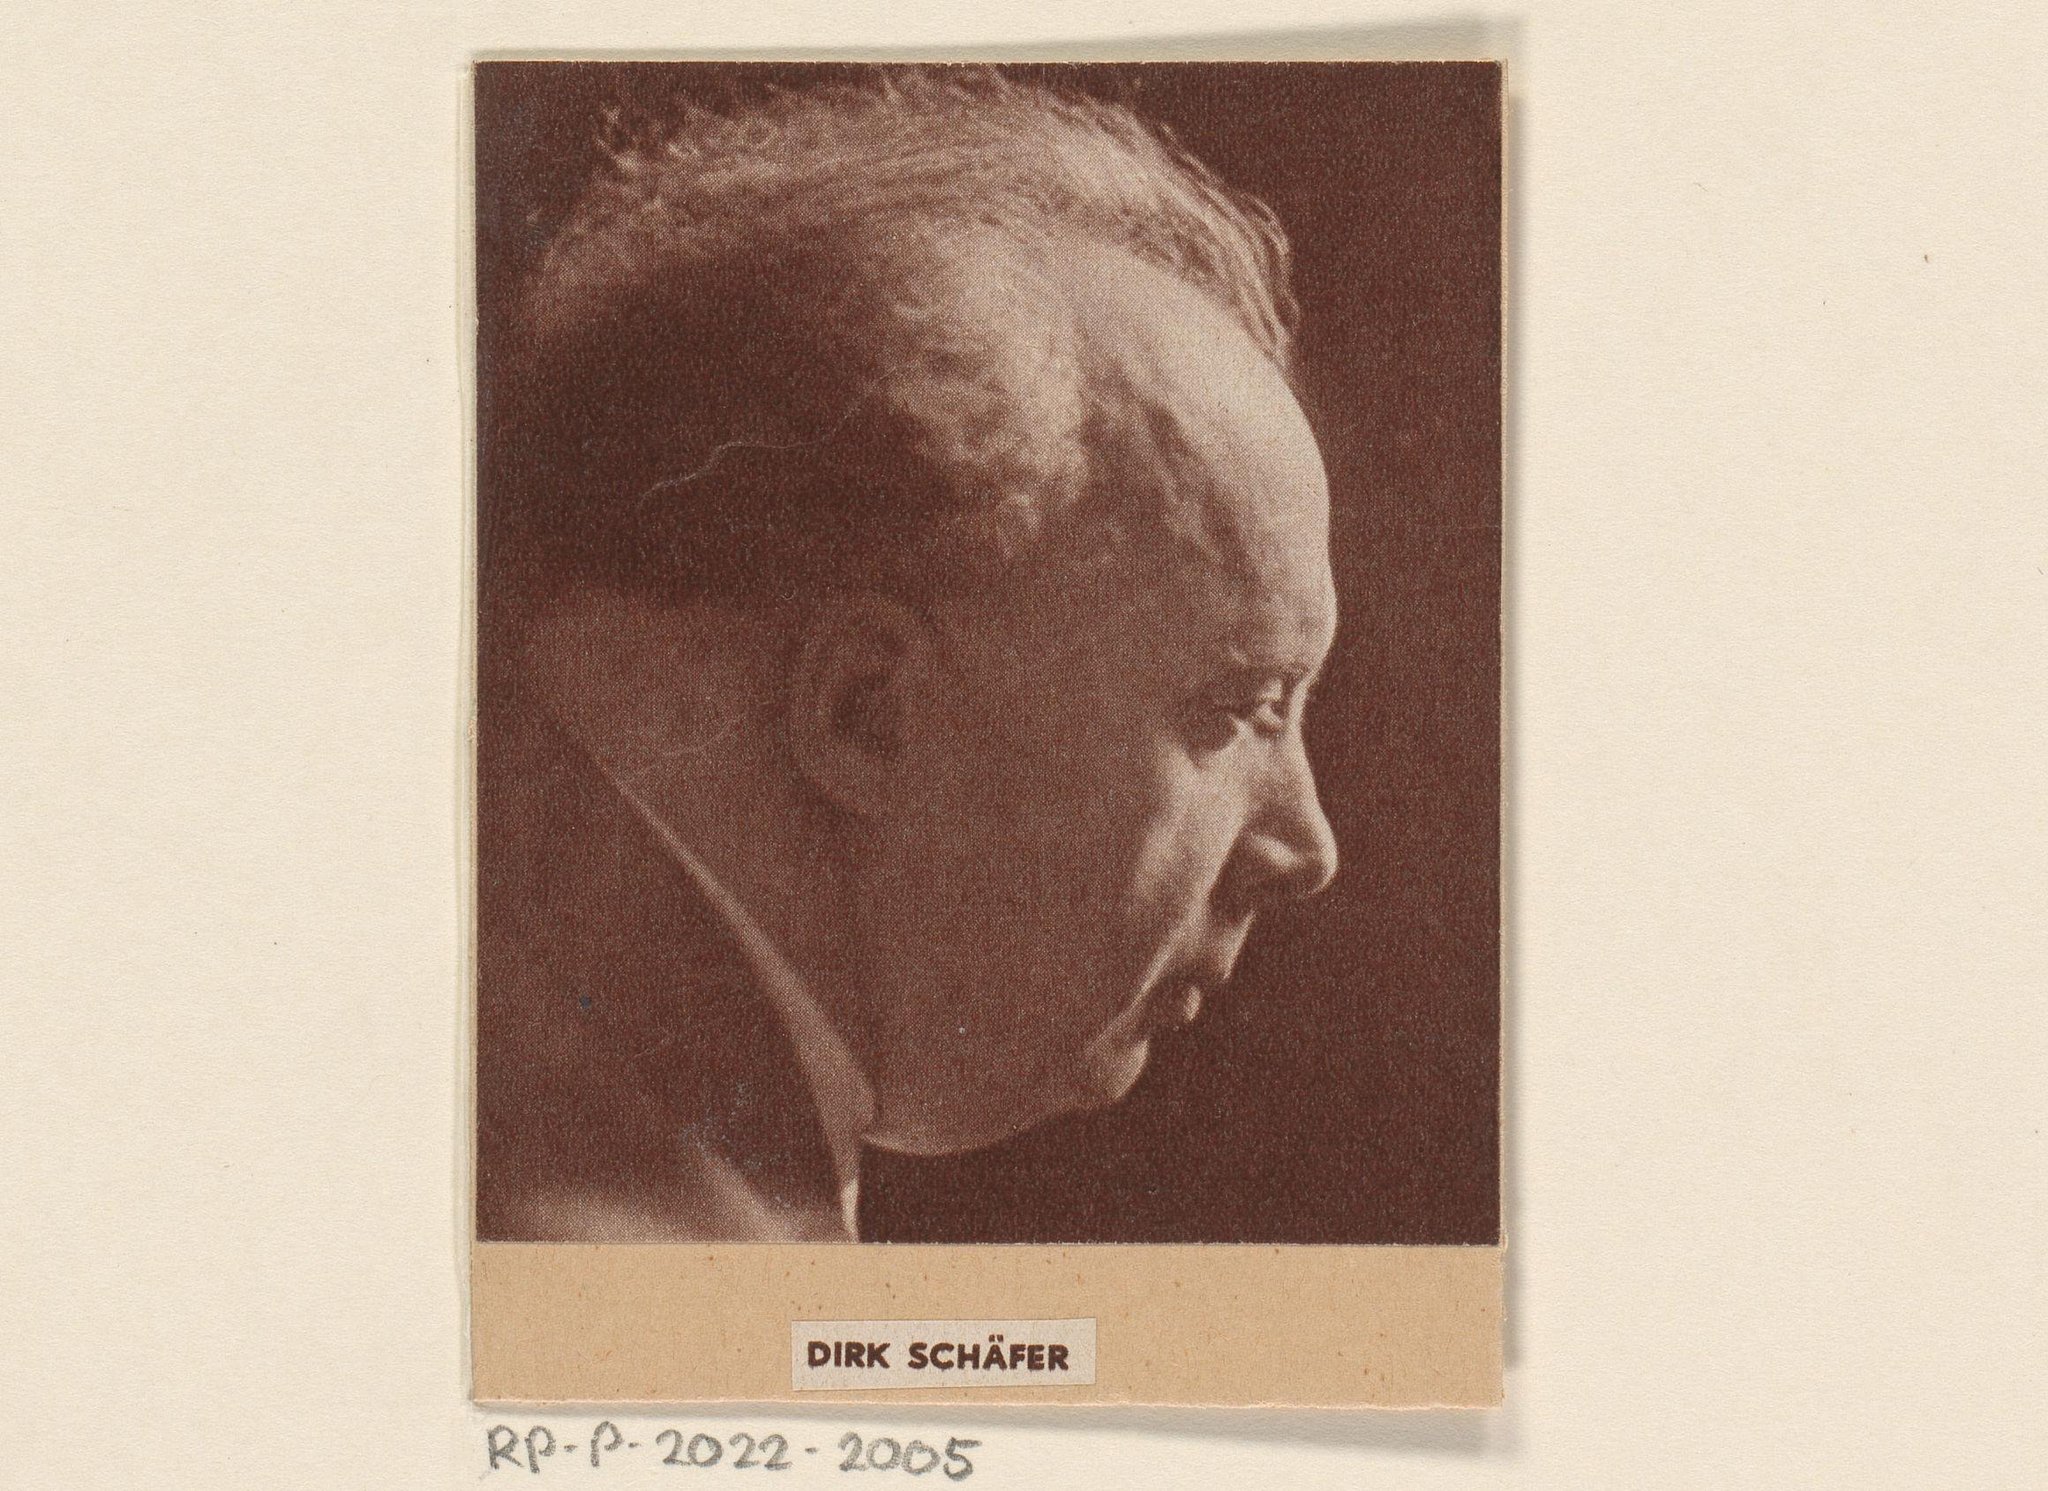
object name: photomechanical print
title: Portret van Dirk Schaefer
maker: Anonymous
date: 1914-1950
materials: paper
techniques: rotogravure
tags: the hague, voorburg, painter, historical persons, portrait, self-portrait of artist